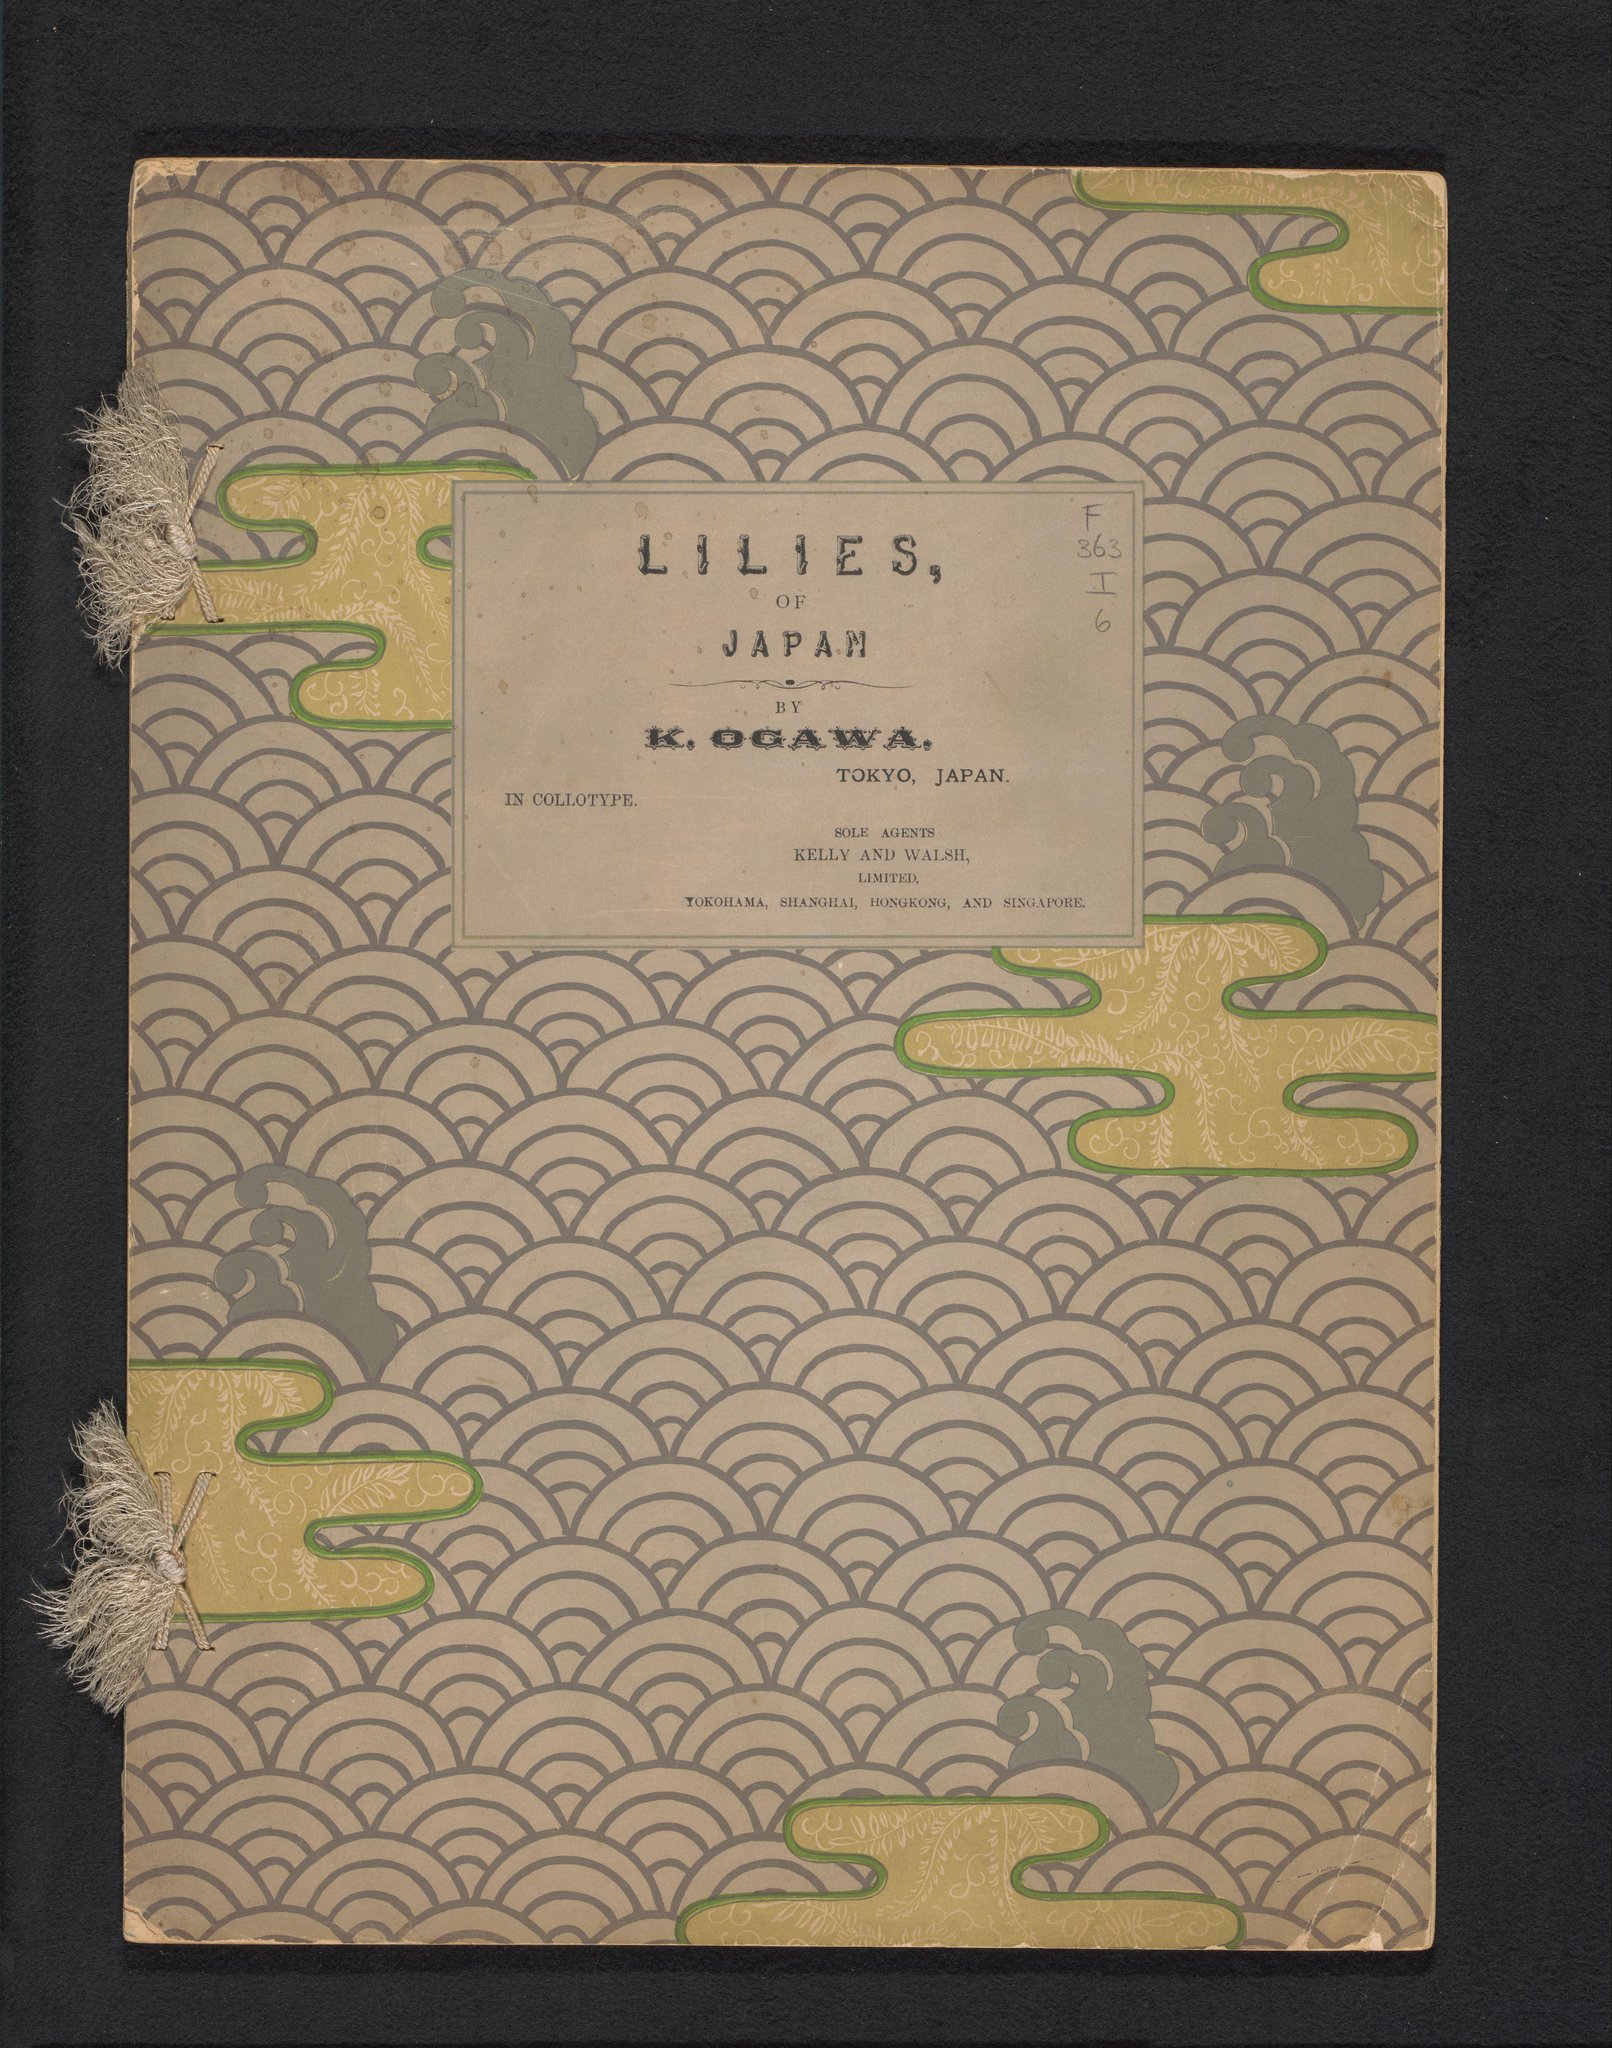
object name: book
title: Lilies, of Japan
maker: kazumasa ogawa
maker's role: auteur, fotograaf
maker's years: 1860-1929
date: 1895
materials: cardboard, linen, paper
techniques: photograph, decorated paper, printing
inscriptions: annotation: ‘76/4251 1+1’, date: ‘NOV 2000’